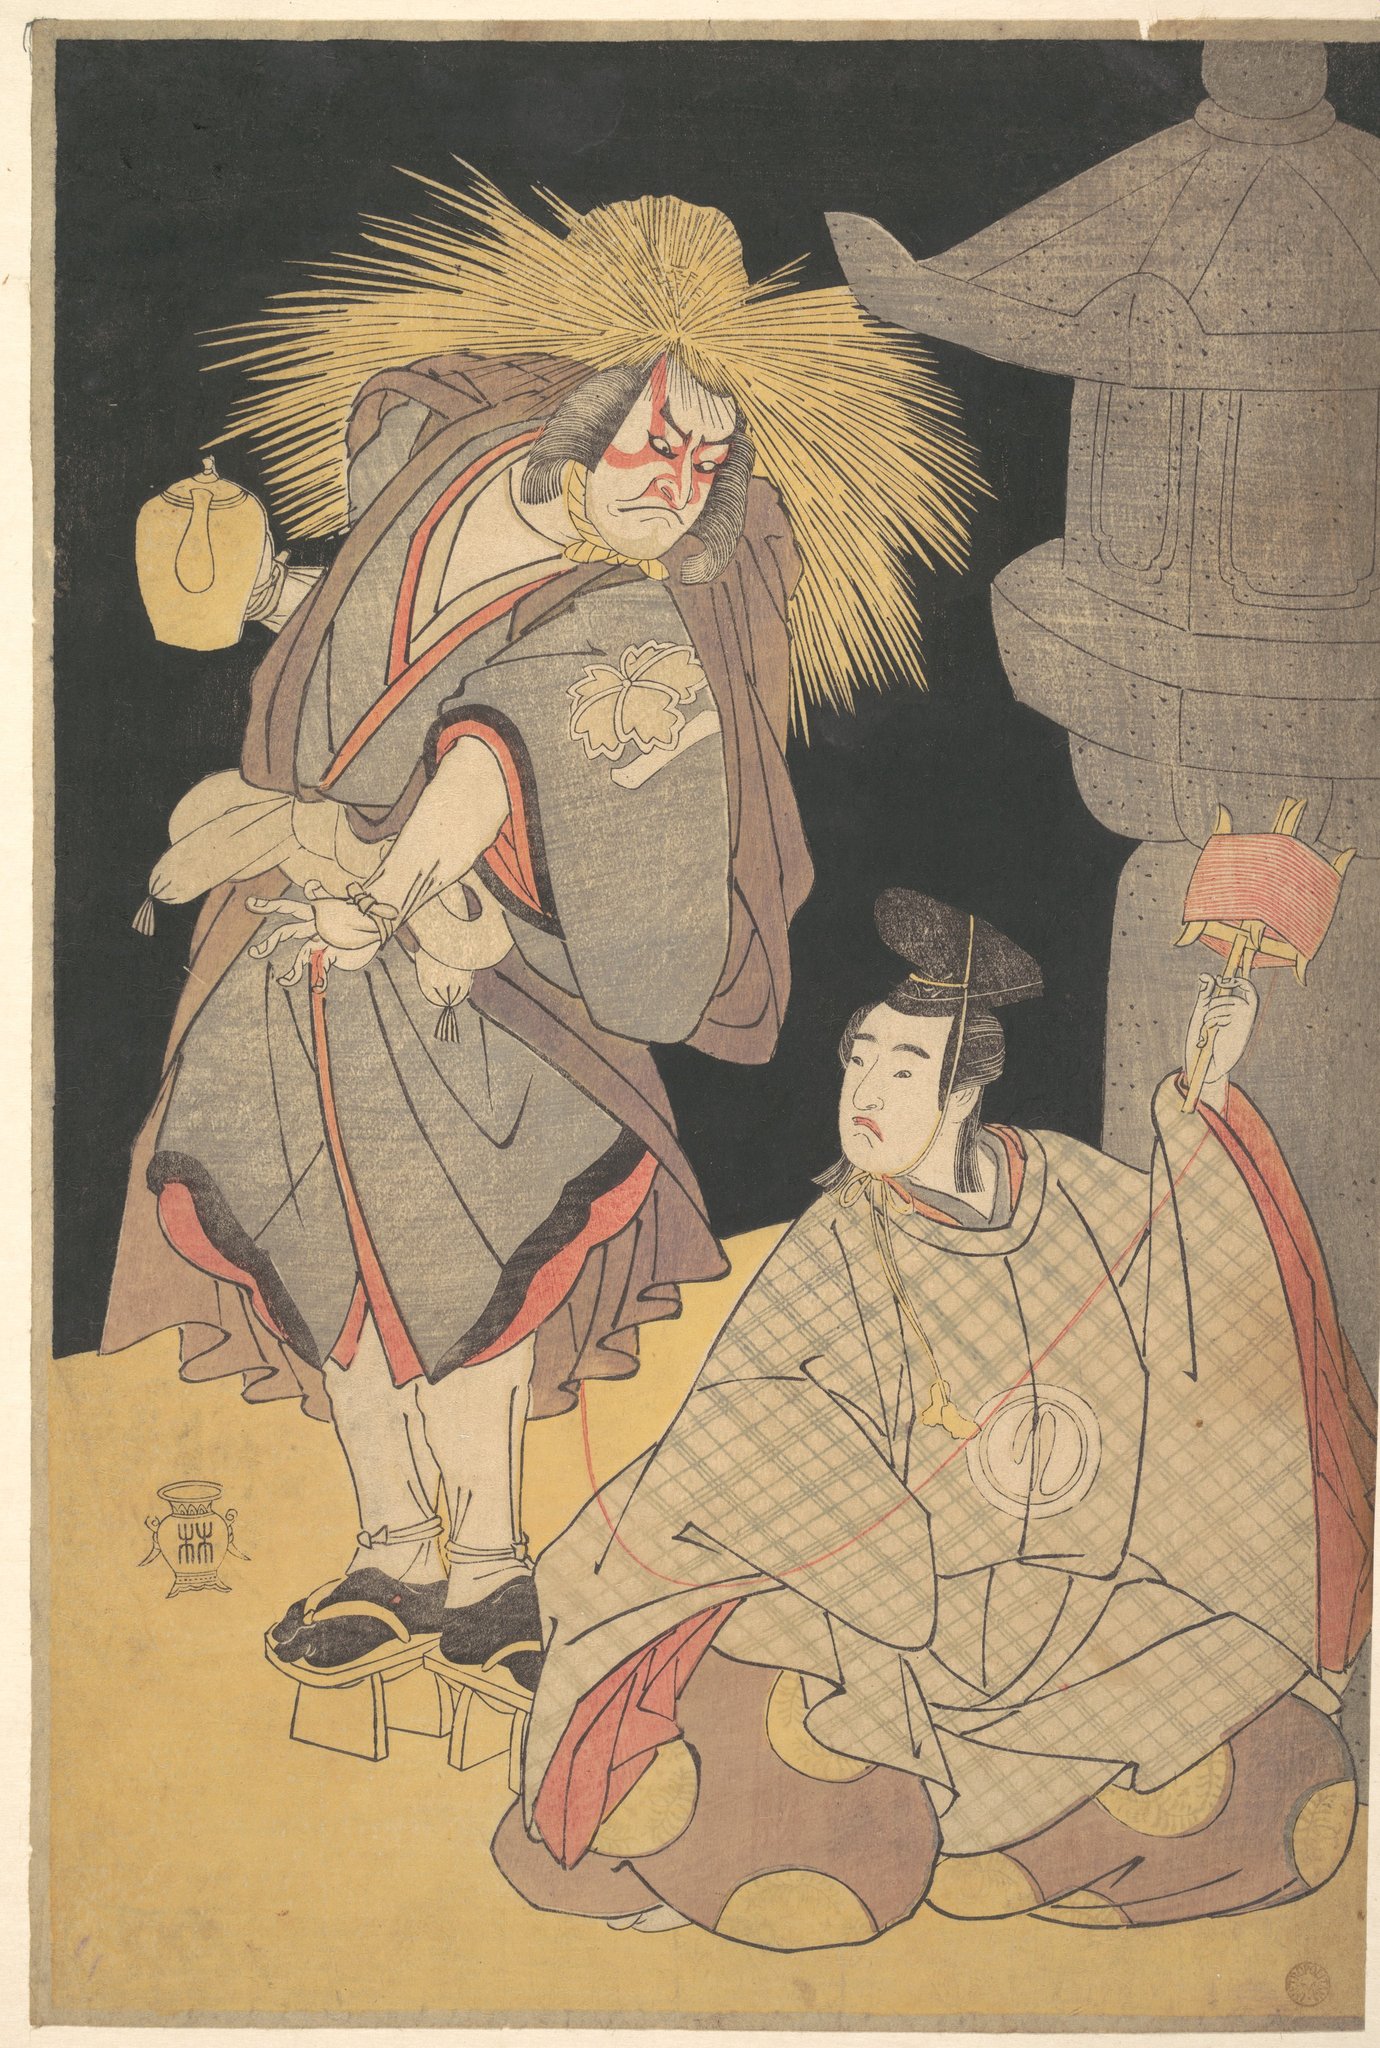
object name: woodblock print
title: Scene from the Drama "Yuki-motsu-take Furisode Genji"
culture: japanese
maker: katsukawa shunkō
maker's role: artist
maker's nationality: japanese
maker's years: 1743-1812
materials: ink, paper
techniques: woodblock print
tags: theatre,men,actors,lamps